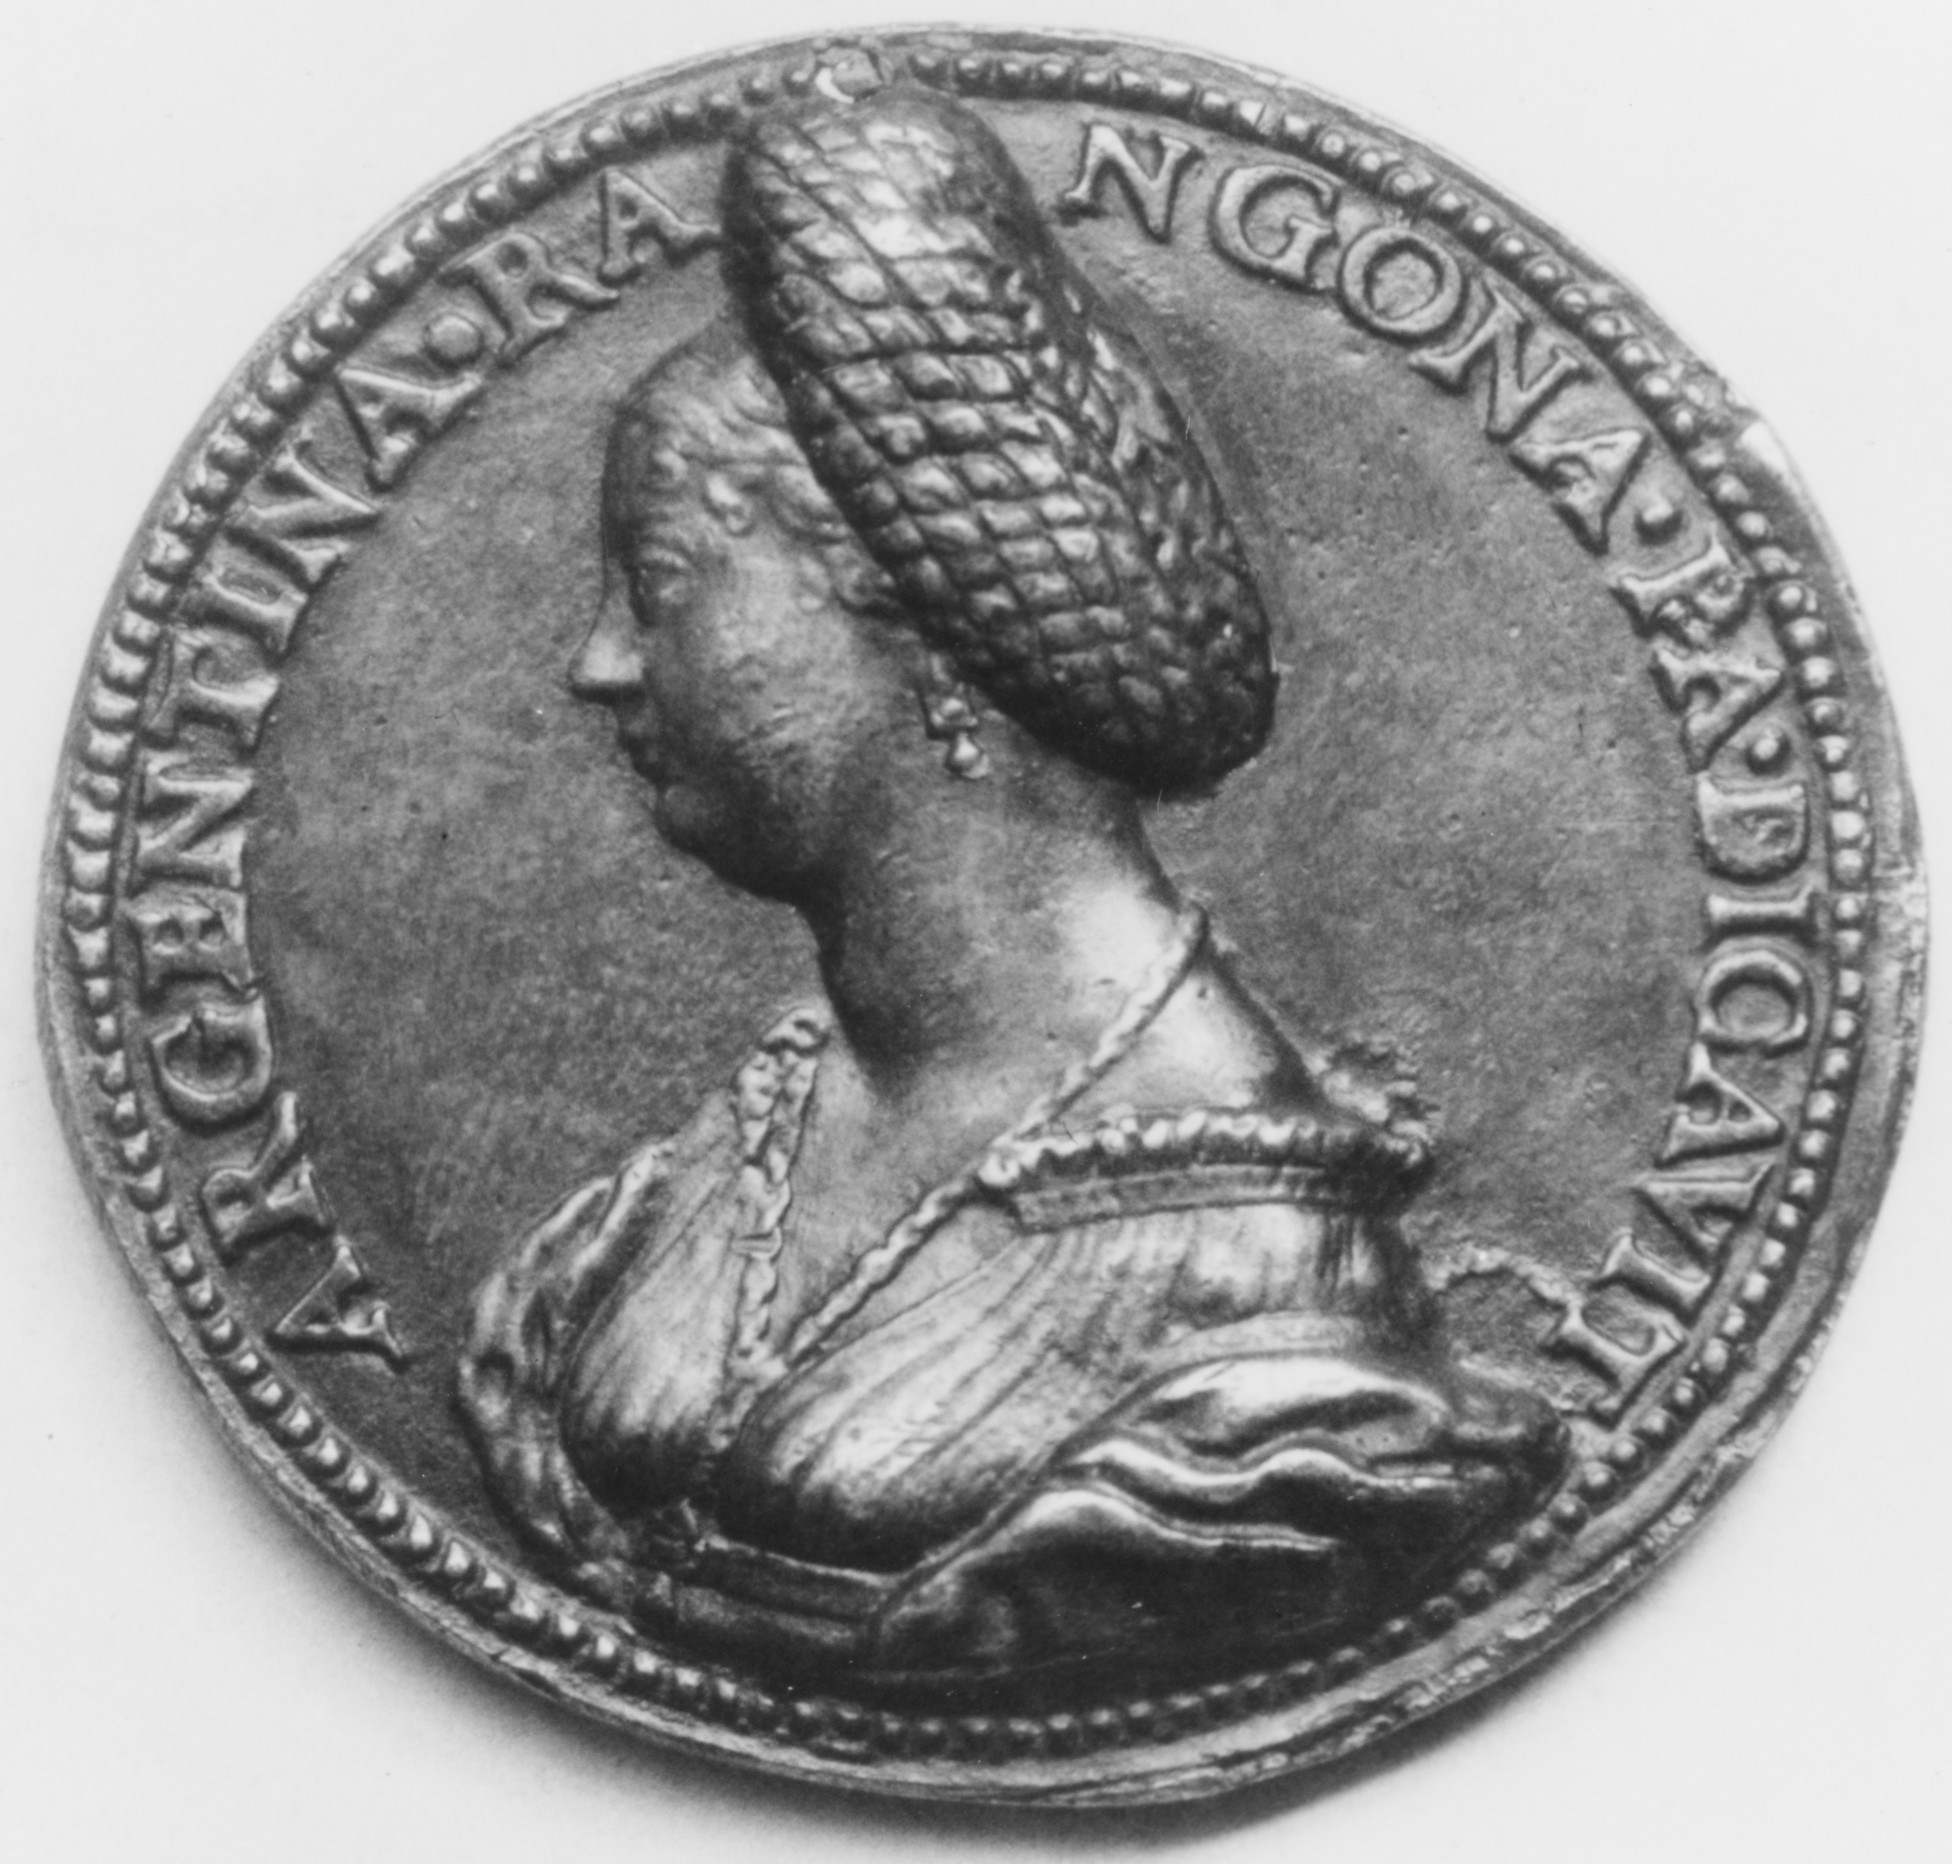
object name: medal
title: Portrait of Argentina Rangona (d. 1550)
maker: niccolo cavallerino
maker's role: artist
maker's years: 1450-1600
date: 1500-1550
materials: bronze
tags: profiles,women